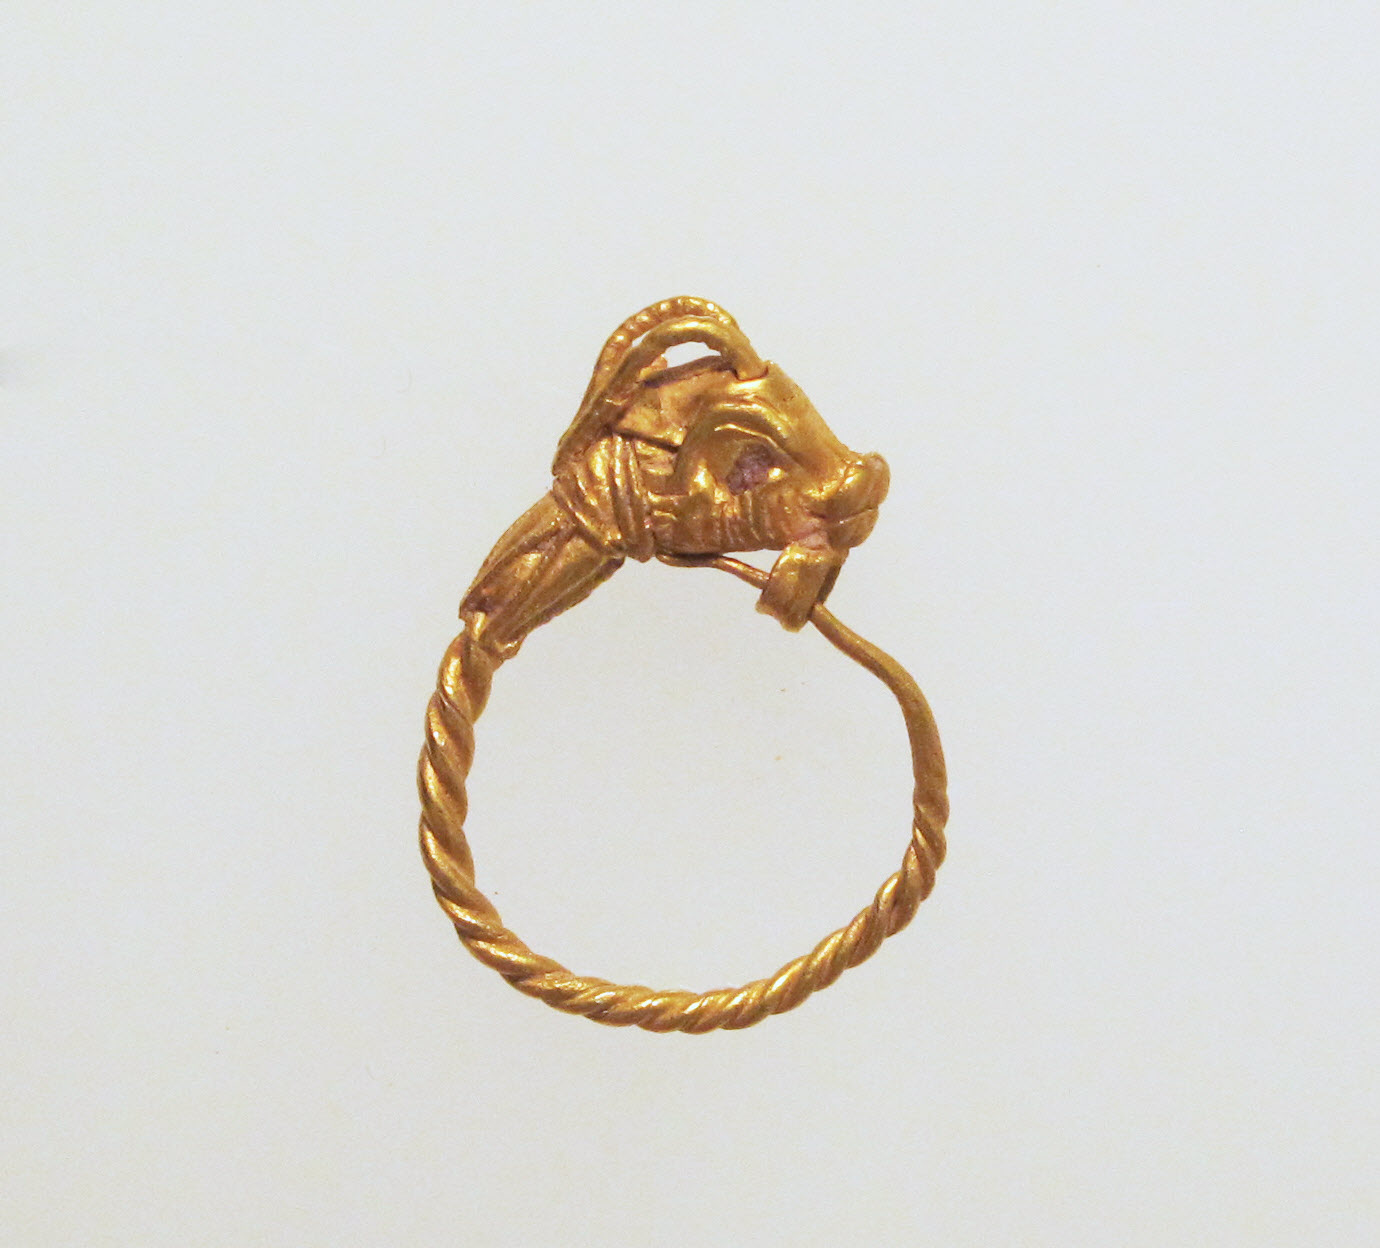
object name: earring with head of goat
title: Gold earring with head of a goat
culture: greek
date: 300-201 BCE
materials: gold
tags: goats